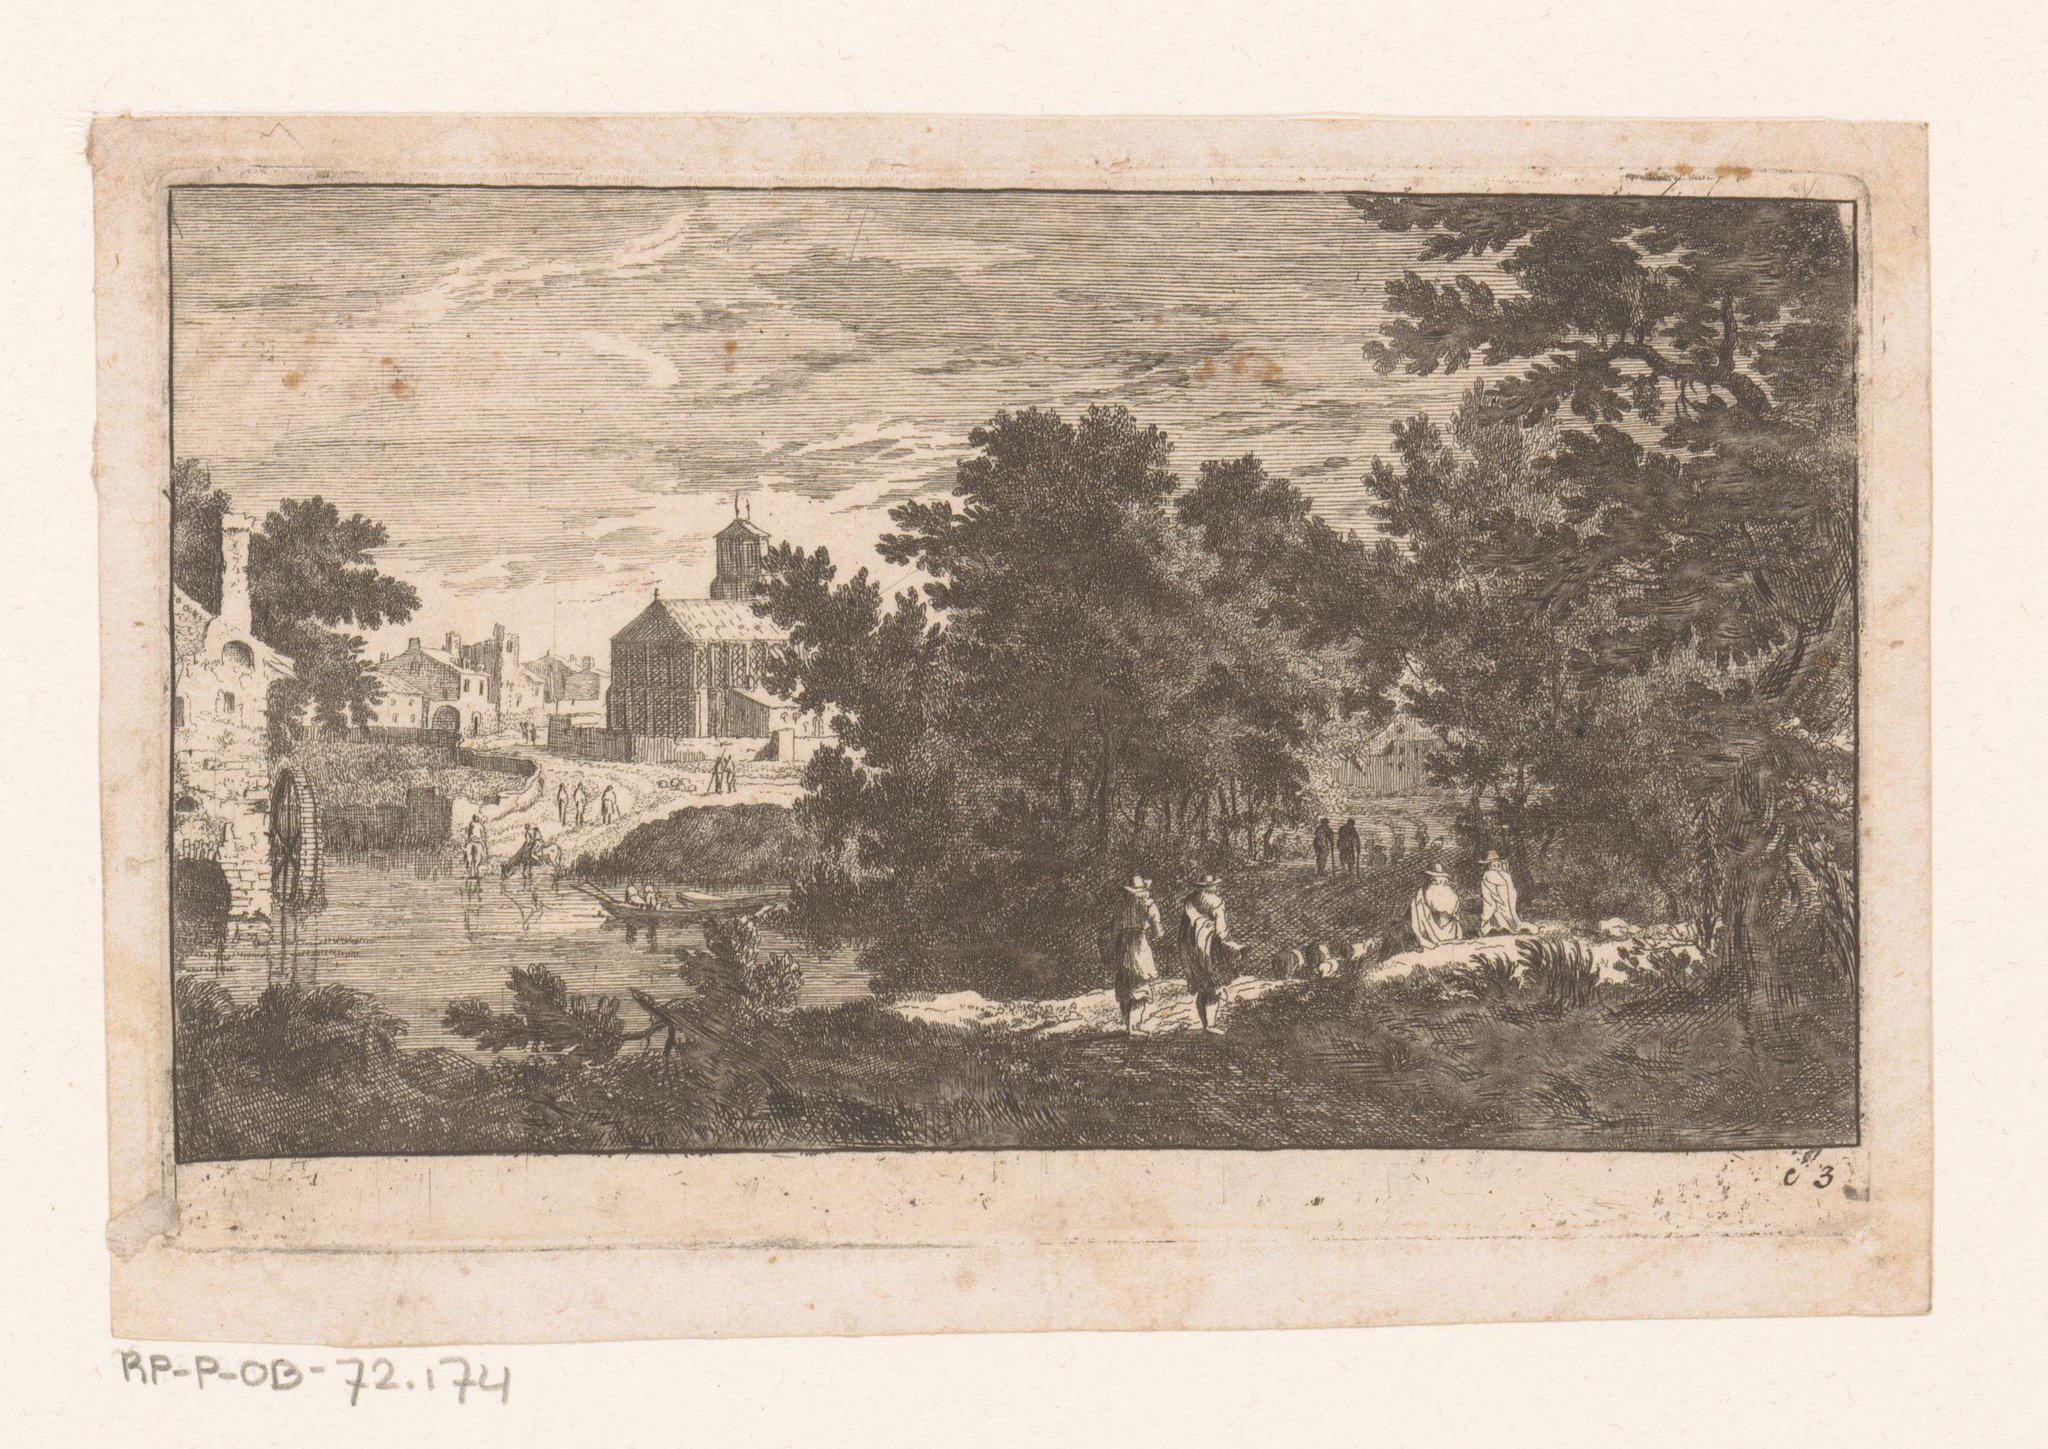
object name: print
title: Gezicht op dorp en watermolen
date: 1613-1695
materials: paper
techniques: etching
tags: watermill in landscape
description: Prenten met het signatuur 'Perelle' kunnen zowel door vader Gabriel als door zonen Nicolas en Adam gemaakt zijn.